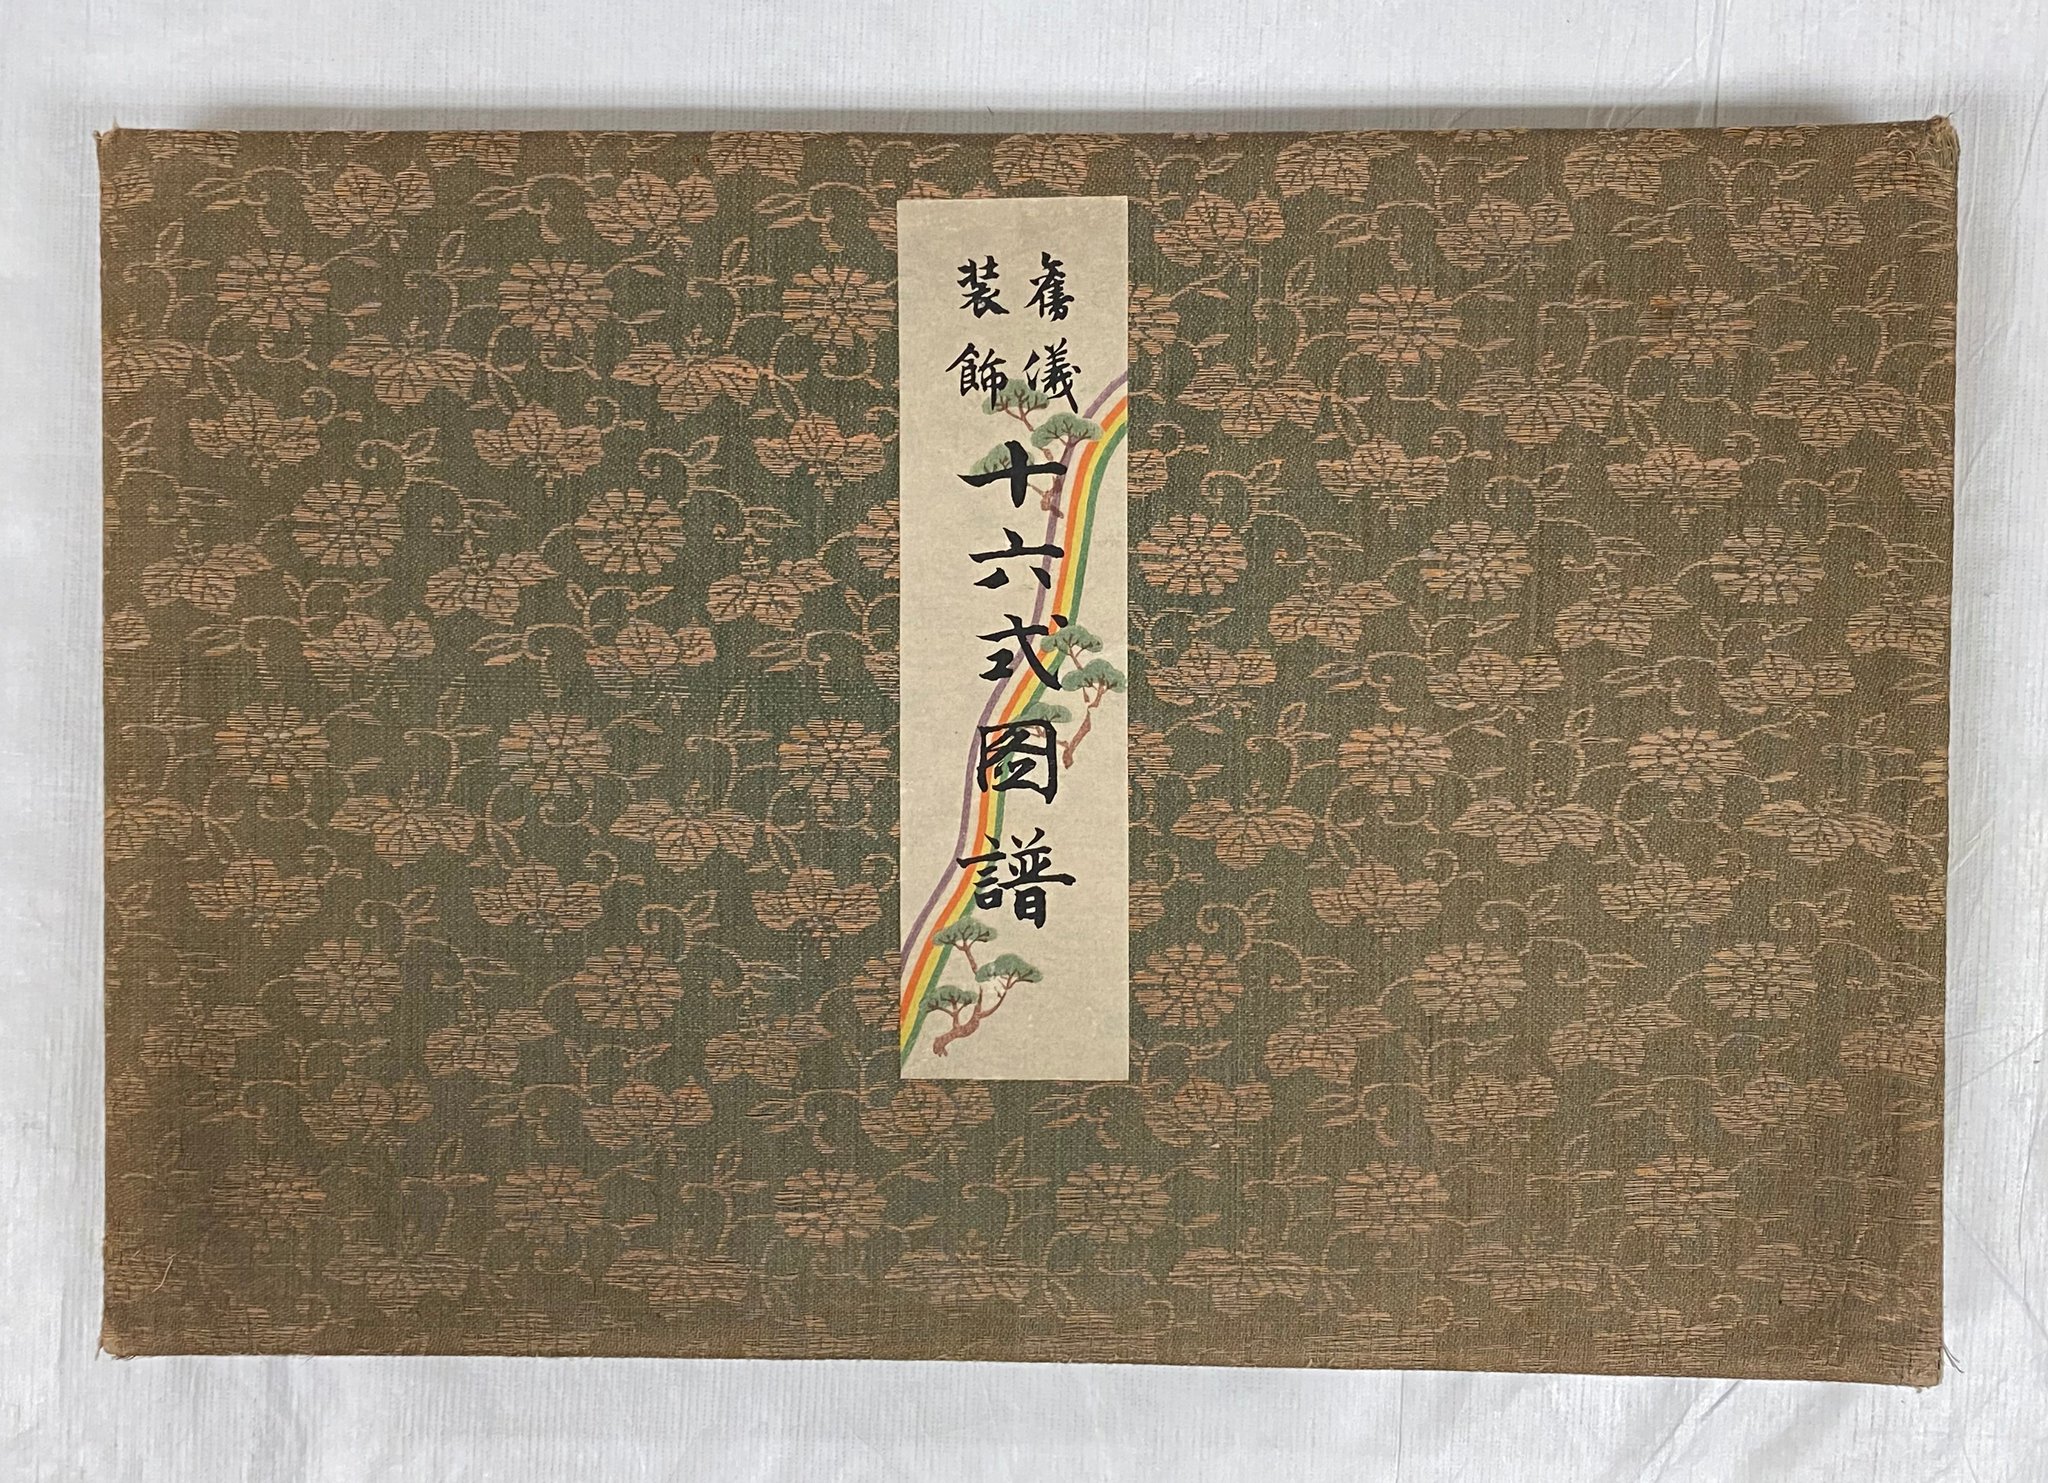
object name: illustrated book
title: Sixteen Illustrations of Ceremonial Decoration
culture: japanese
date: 1903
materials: ink, paper